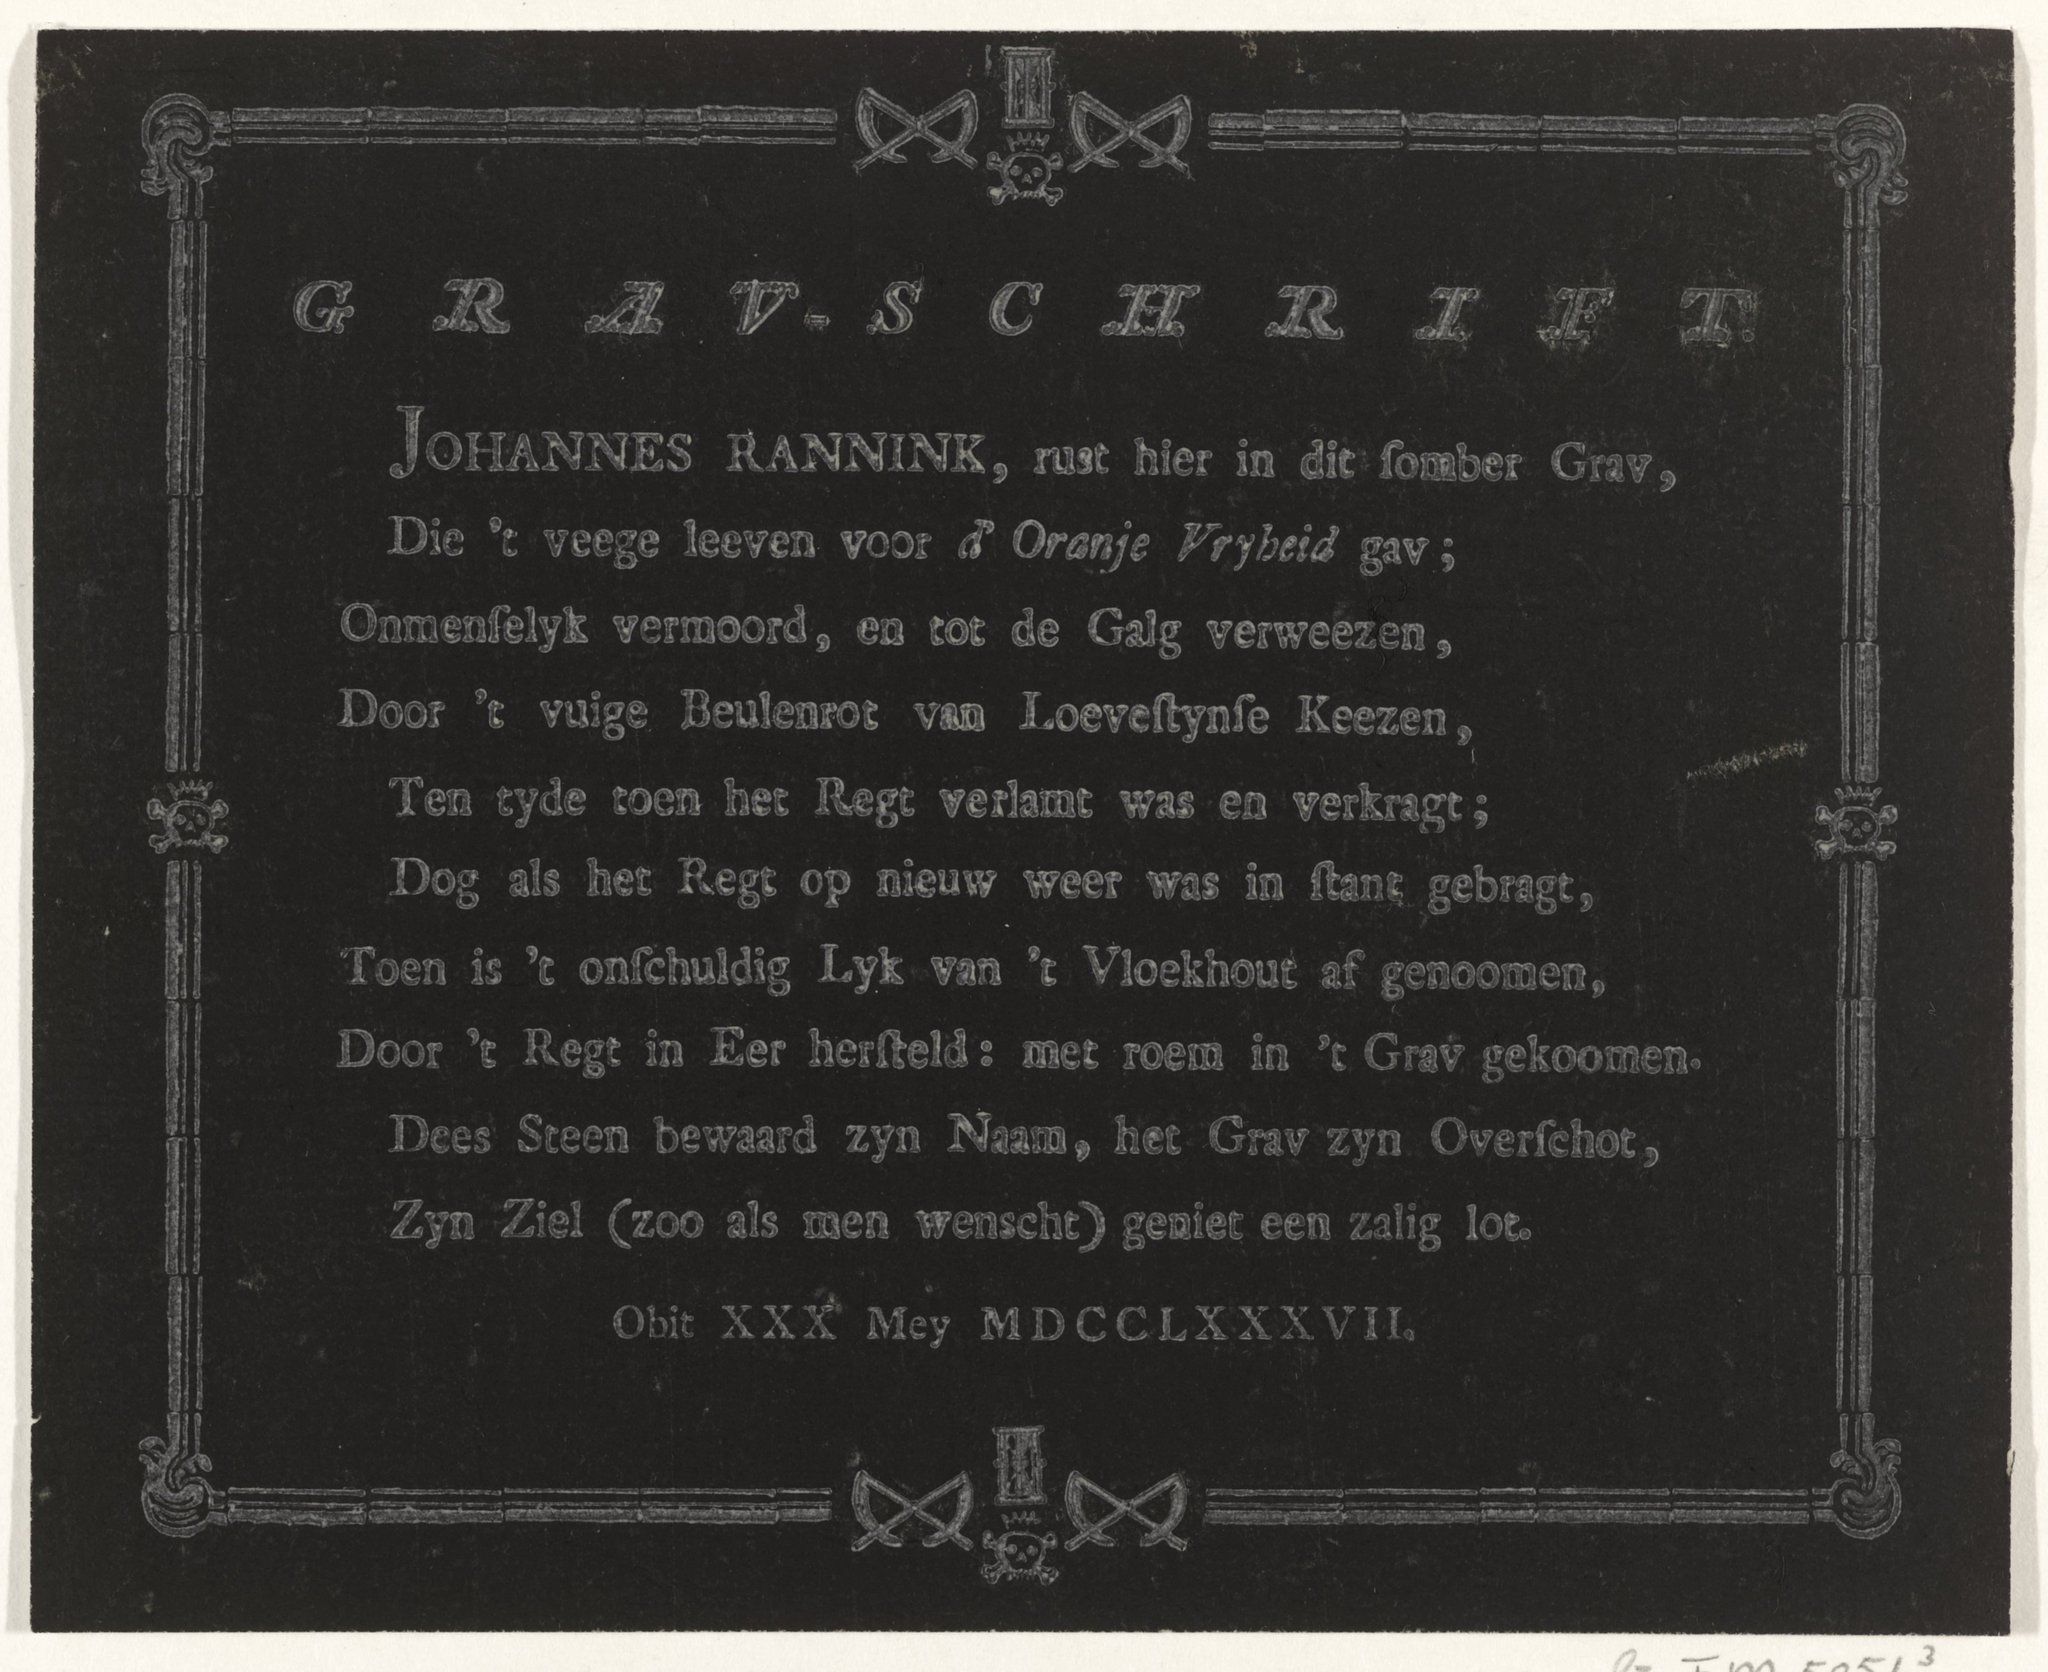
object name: text sheet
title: Grav-schrift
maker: Anonymous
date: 1712-1787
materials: paper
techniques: letterpress printing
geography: northern netherlands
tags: scheepstimmerman, johannes rannink, kattenburg, kattenburgoproer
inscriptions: collector's mark: Lugt 2228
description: Zwart blad met een grafschrift voor Johannes Rannink, aanvoerder van de bijltjes, de opstandige Oranjegezinde Amsterdamse scheepstimmerlieden die op het eiland Kattenburg in opstand kwamen tegen het patriotse stadsbestuur. Gesneuveld op 30 mei 1787 en begraven op 8 december 1787. Tekst gedrukt in wit in een omlijsting versierd met doodskoppen, zandlopers en gekruiste zeisen.